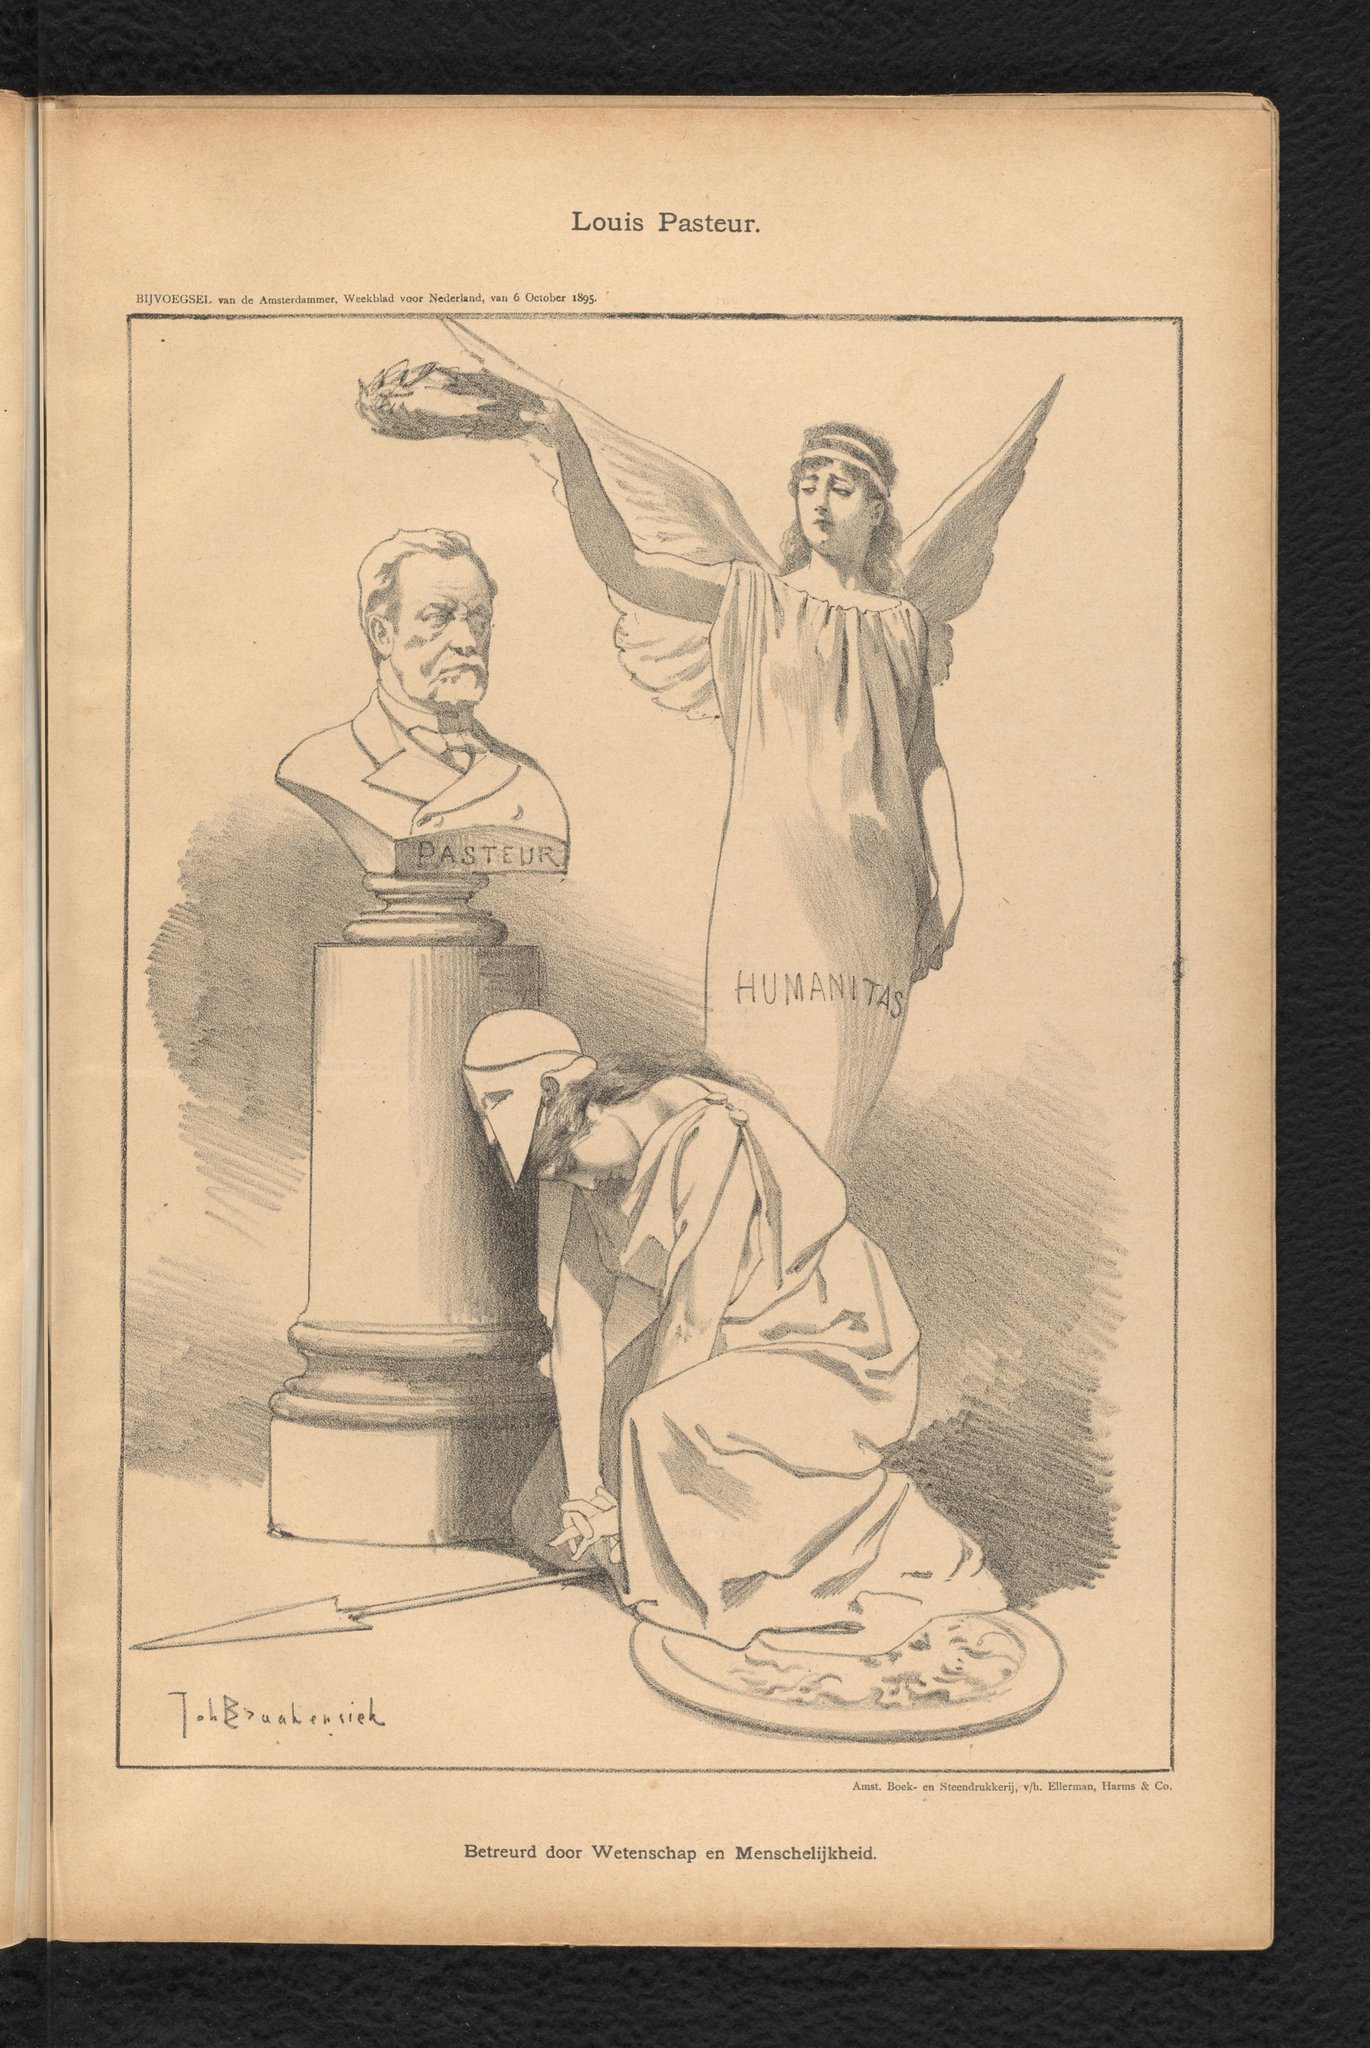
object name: print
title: Louis Pasteur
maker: johan braakensiek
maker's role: draughtsman, print maker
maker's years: 1858-1940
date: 1895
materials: paper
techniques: lithograph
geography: netherlands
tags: symbolic representations, allegories and emblems ~ science, 'scientia'; 'scienza', 'studio' (ripa), piece of sculpture, reproduction of a piece of sculpture, mourning the dead, political caricatures and satires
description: De Wetenschap en de Menselijkheid rouwen bij een buste van de Franse scheikundige en bioloog Louis Pasteur, overleden op 28 september 1895.